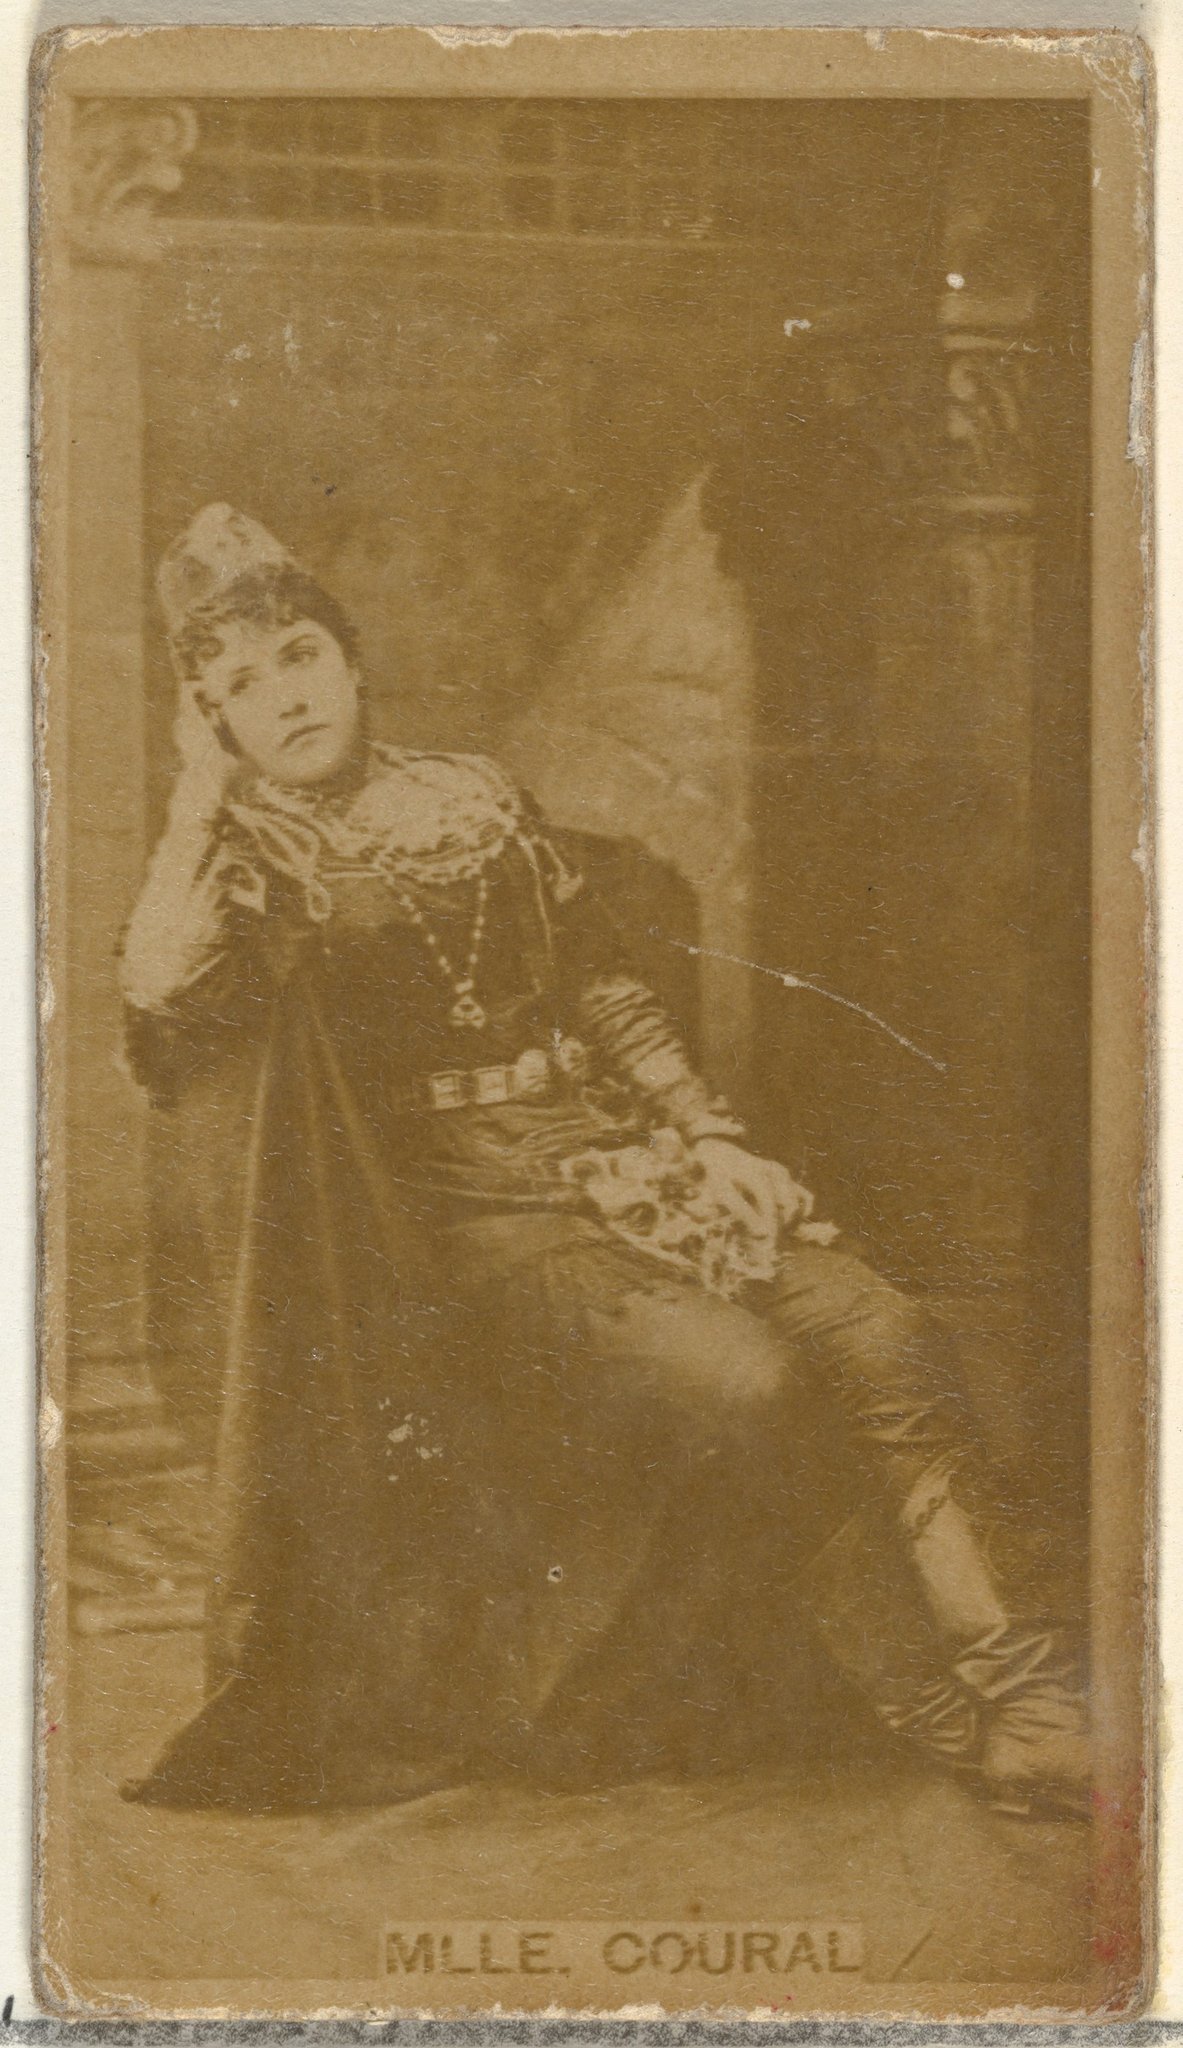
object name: photograph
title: Mlle. Coural, from the Actors and Actresses series (N145-8) issued by Duke Sons & Co. to promote Duke Cigarettes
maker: w. duke, sons & co.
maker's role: publisher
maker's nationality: american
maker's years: 1870-1920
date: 1891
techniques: albumen silver print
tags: portraits,women,actresses